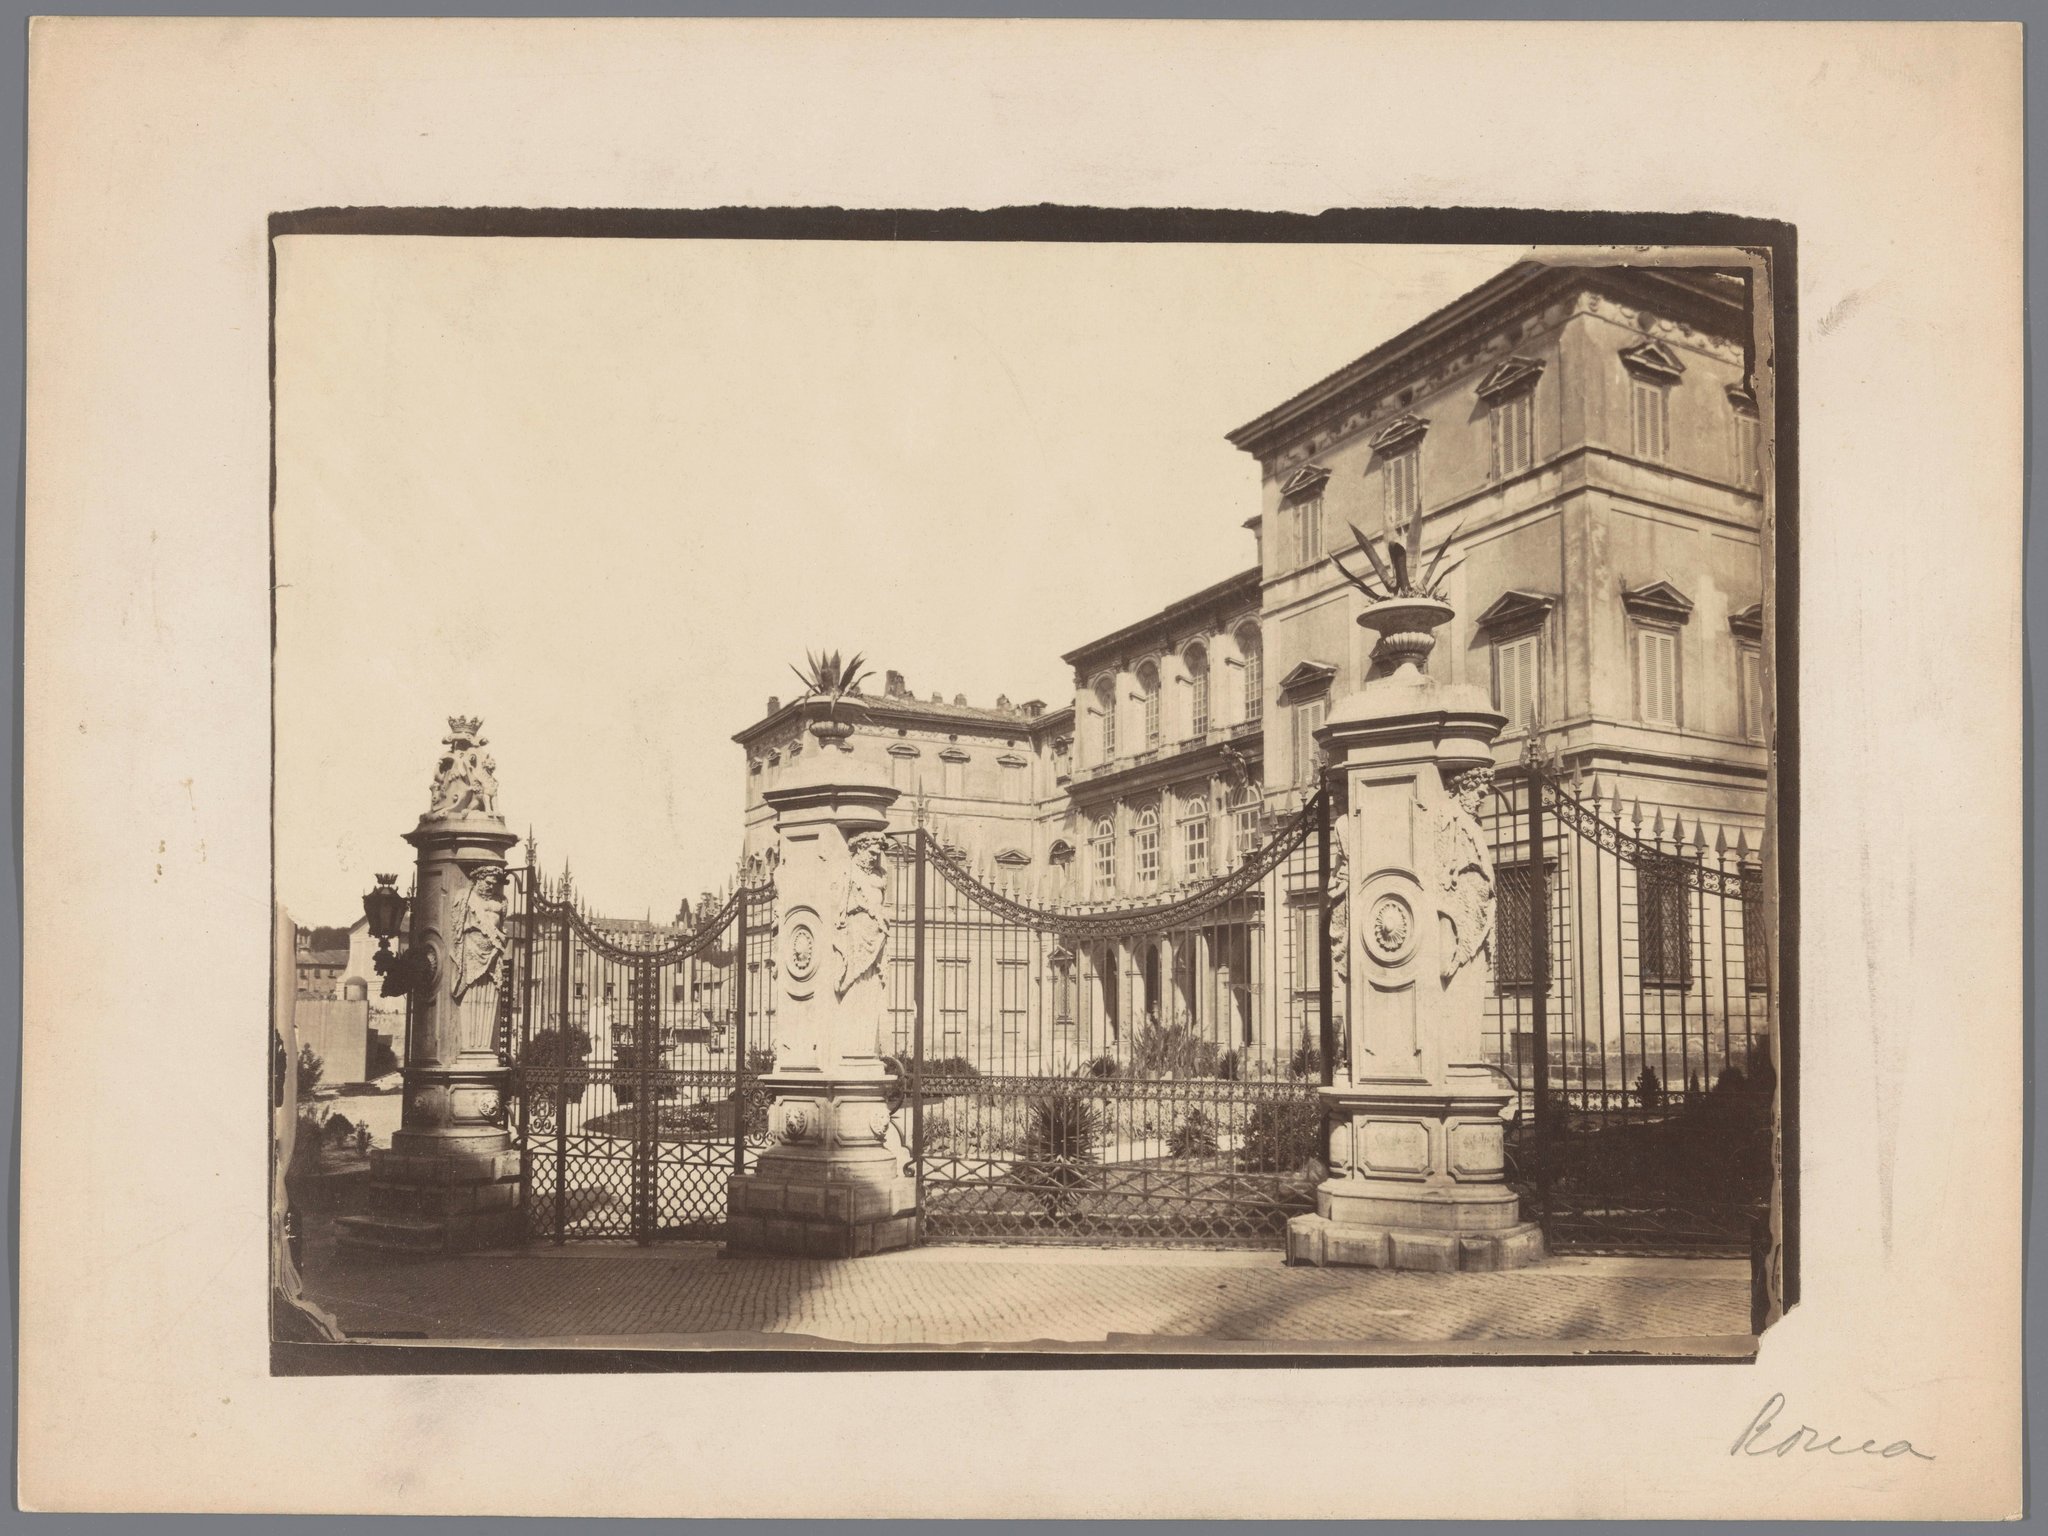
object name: photograph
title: Gezicht op een villa (vermoedelijk) te Rome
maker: gustave eugène chauffourier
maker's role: fotograaf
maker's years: 1845-1919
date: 1875-1900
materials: photographic support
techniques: albumen print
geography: rome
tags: fence, wall, paling, villa, façade (of house or building)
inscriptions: collector's mark: Lugt 3937